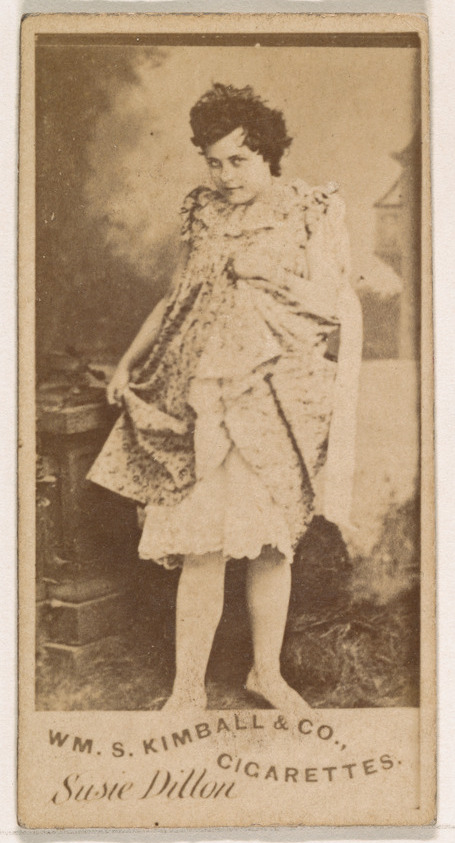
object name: photograph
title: Susie Dillon, from the Actresses series (N203) issued by Wm. S. Kimball & Co.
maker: william s. kimball & company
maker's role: publisher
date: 1889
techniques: color lithograph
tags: portraits,women,actresses